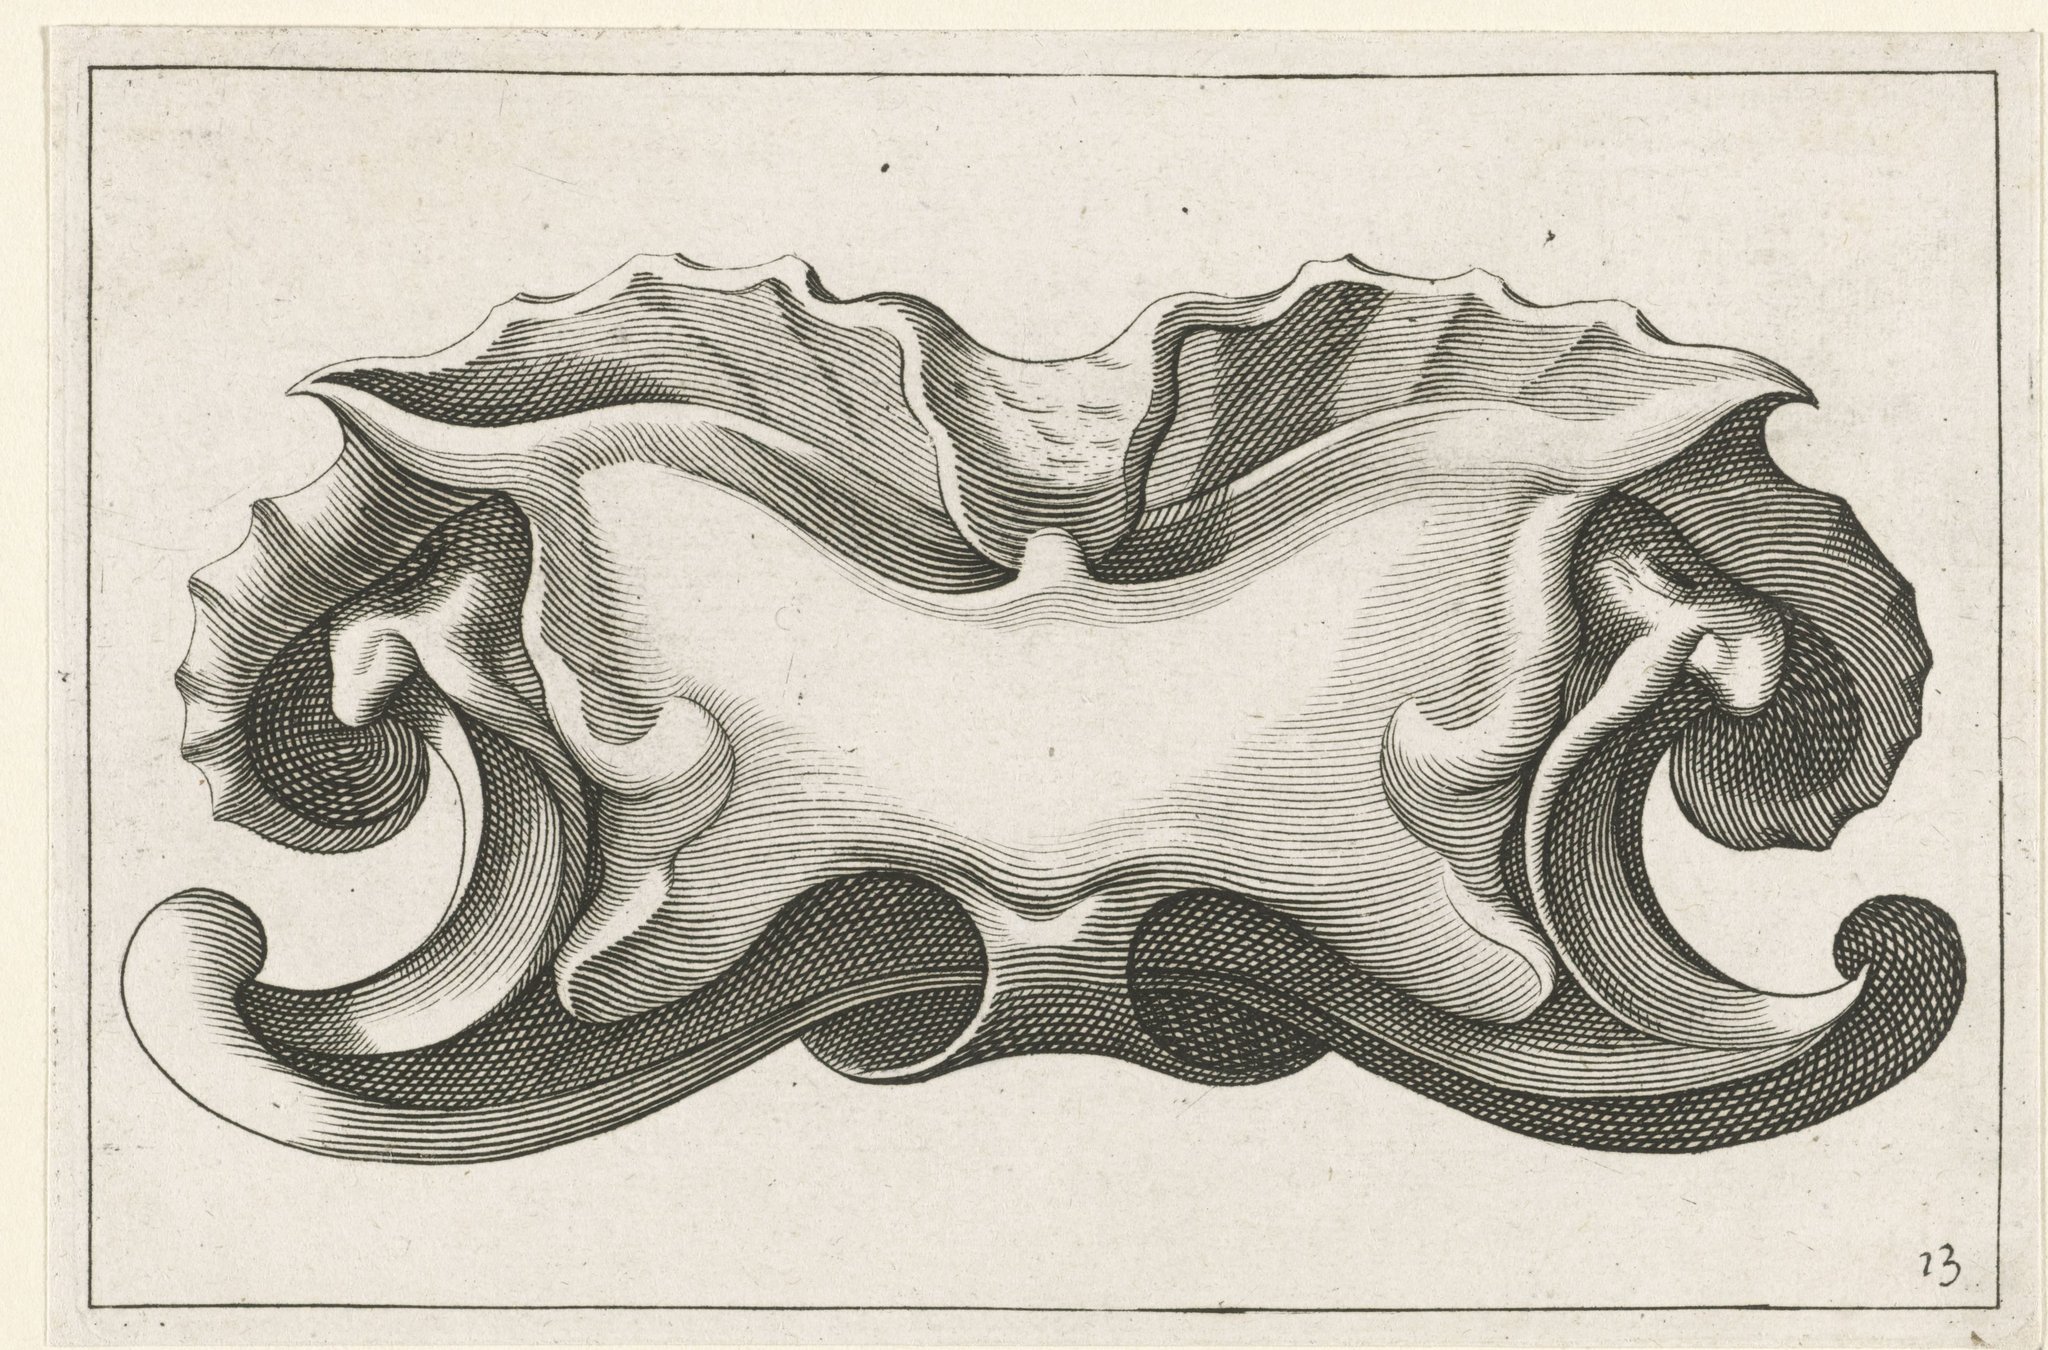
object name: ornament print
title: Differents Conpartimens et Chapiteaux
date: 1657-1685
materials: paper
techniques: engraving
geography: paris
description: Uit serie van 22 of 29 bladen met cartouches in Italiaanse kwabstijl, vierde editie.